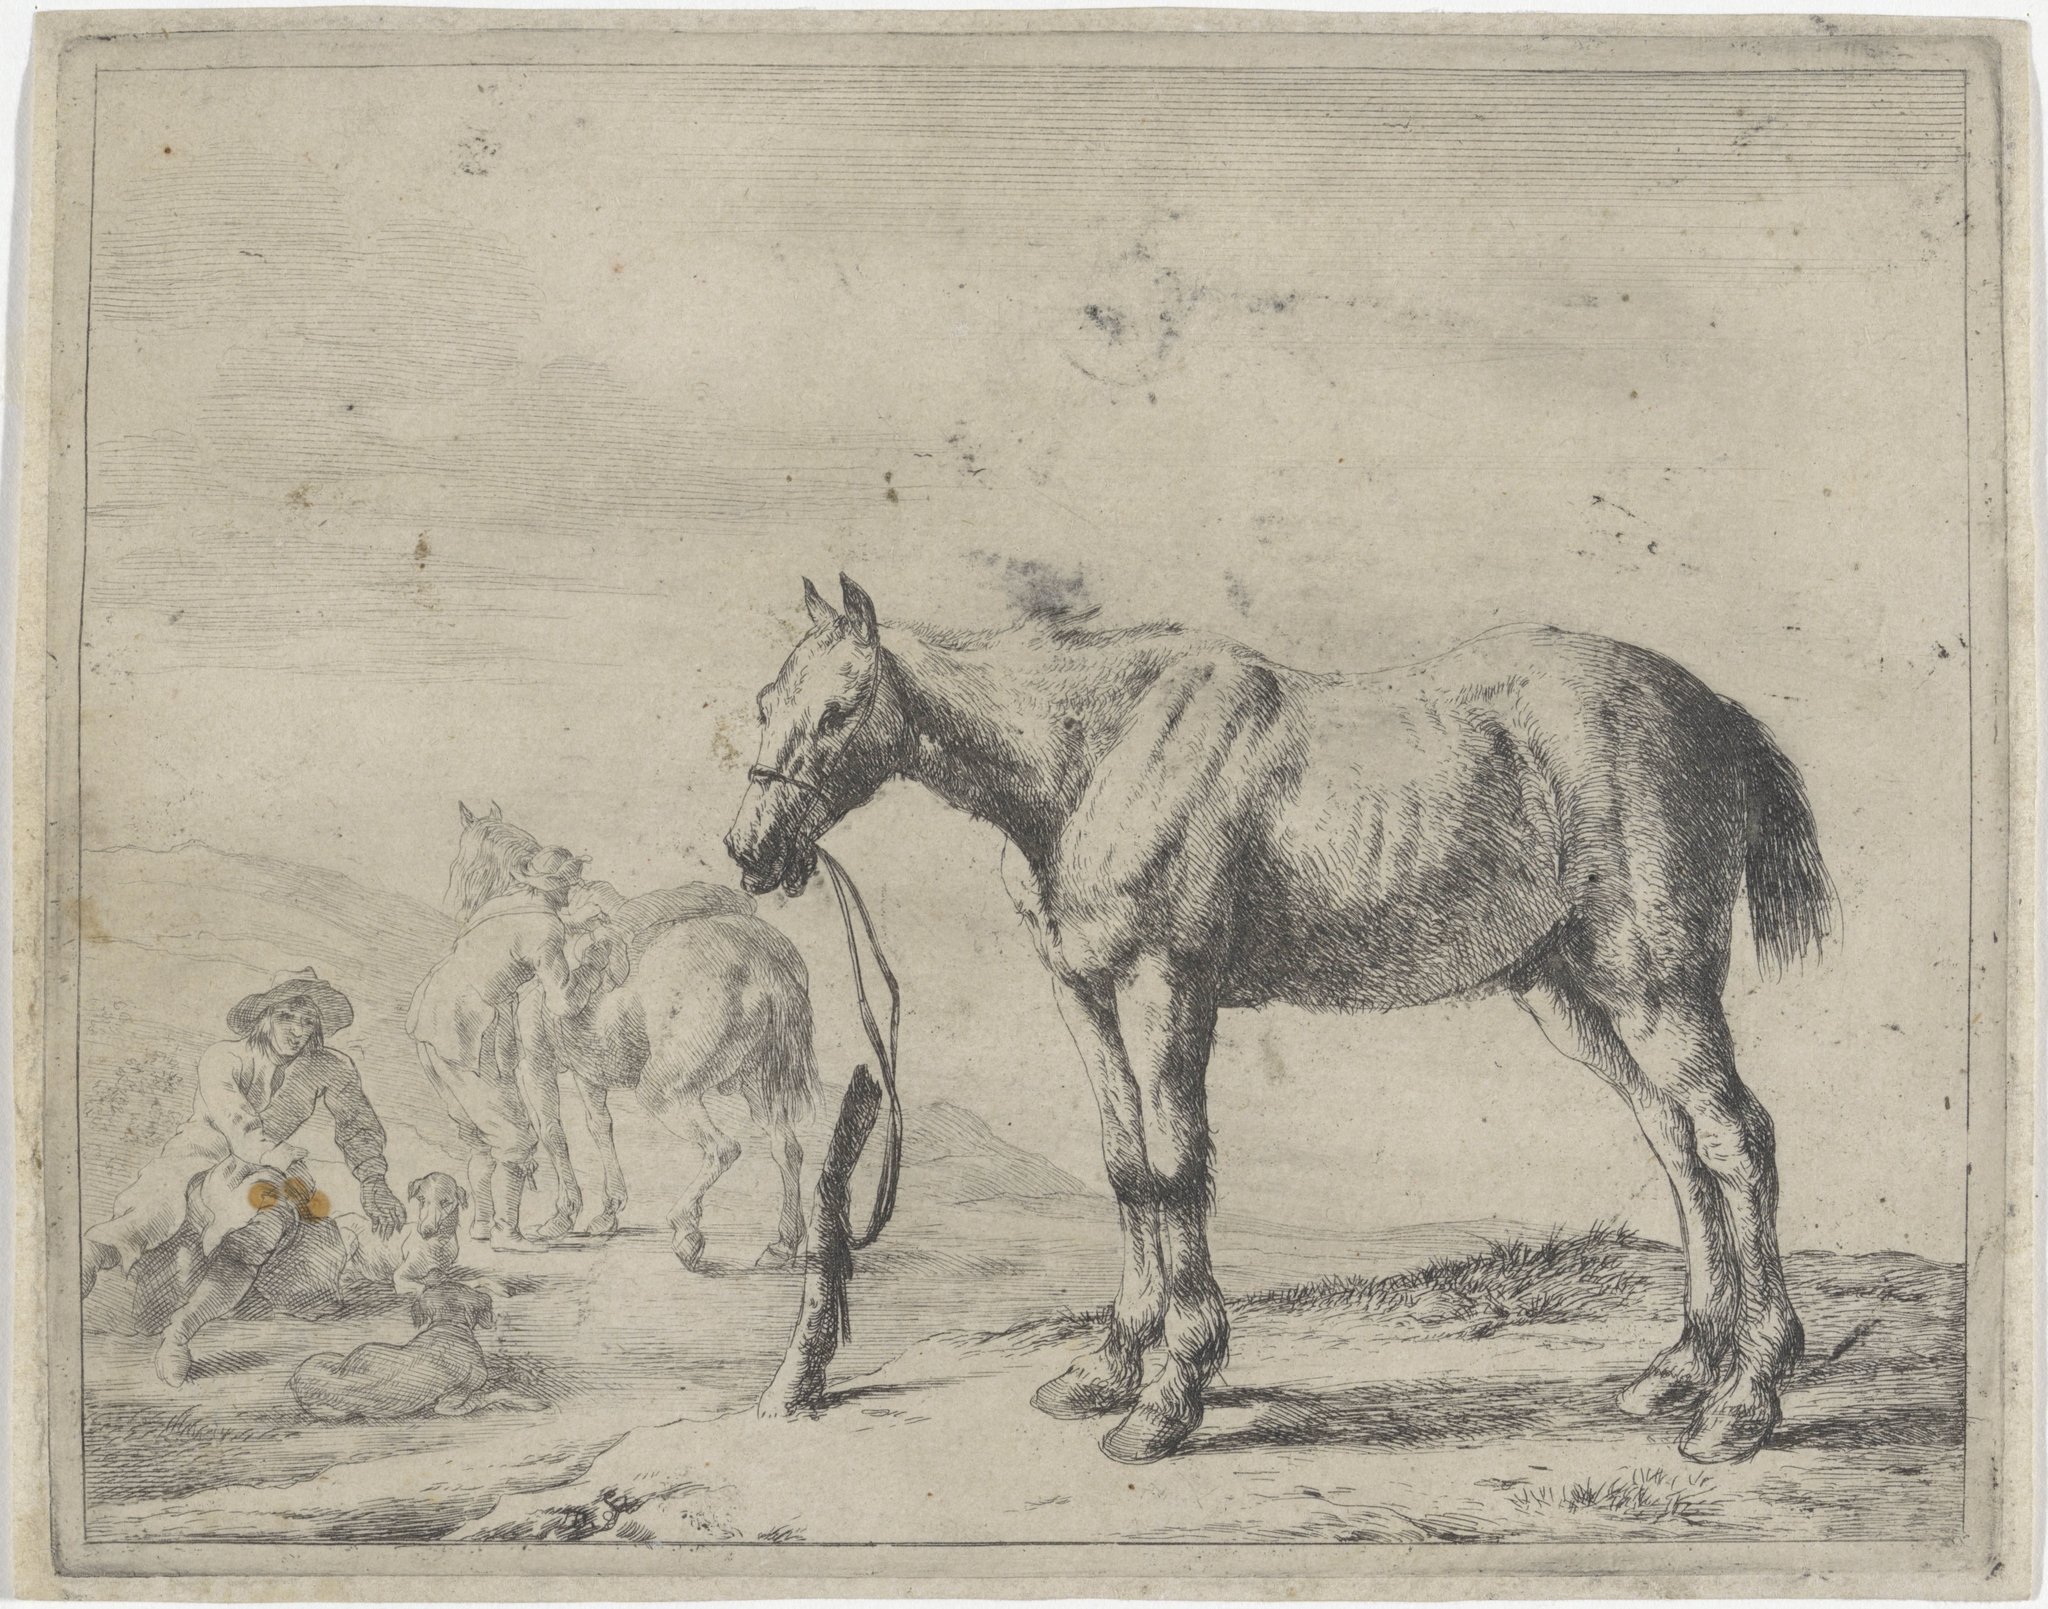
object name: print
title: Aan een paal gebonden paard naar links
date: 1651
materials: paper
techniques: etching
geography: utrecht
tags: horse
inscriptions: collector's mark: Lugt 2228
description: Een aan een paal gebonden paard. Links een rustende ruiter en twee honden. Daarachter een man bij een ander paard.